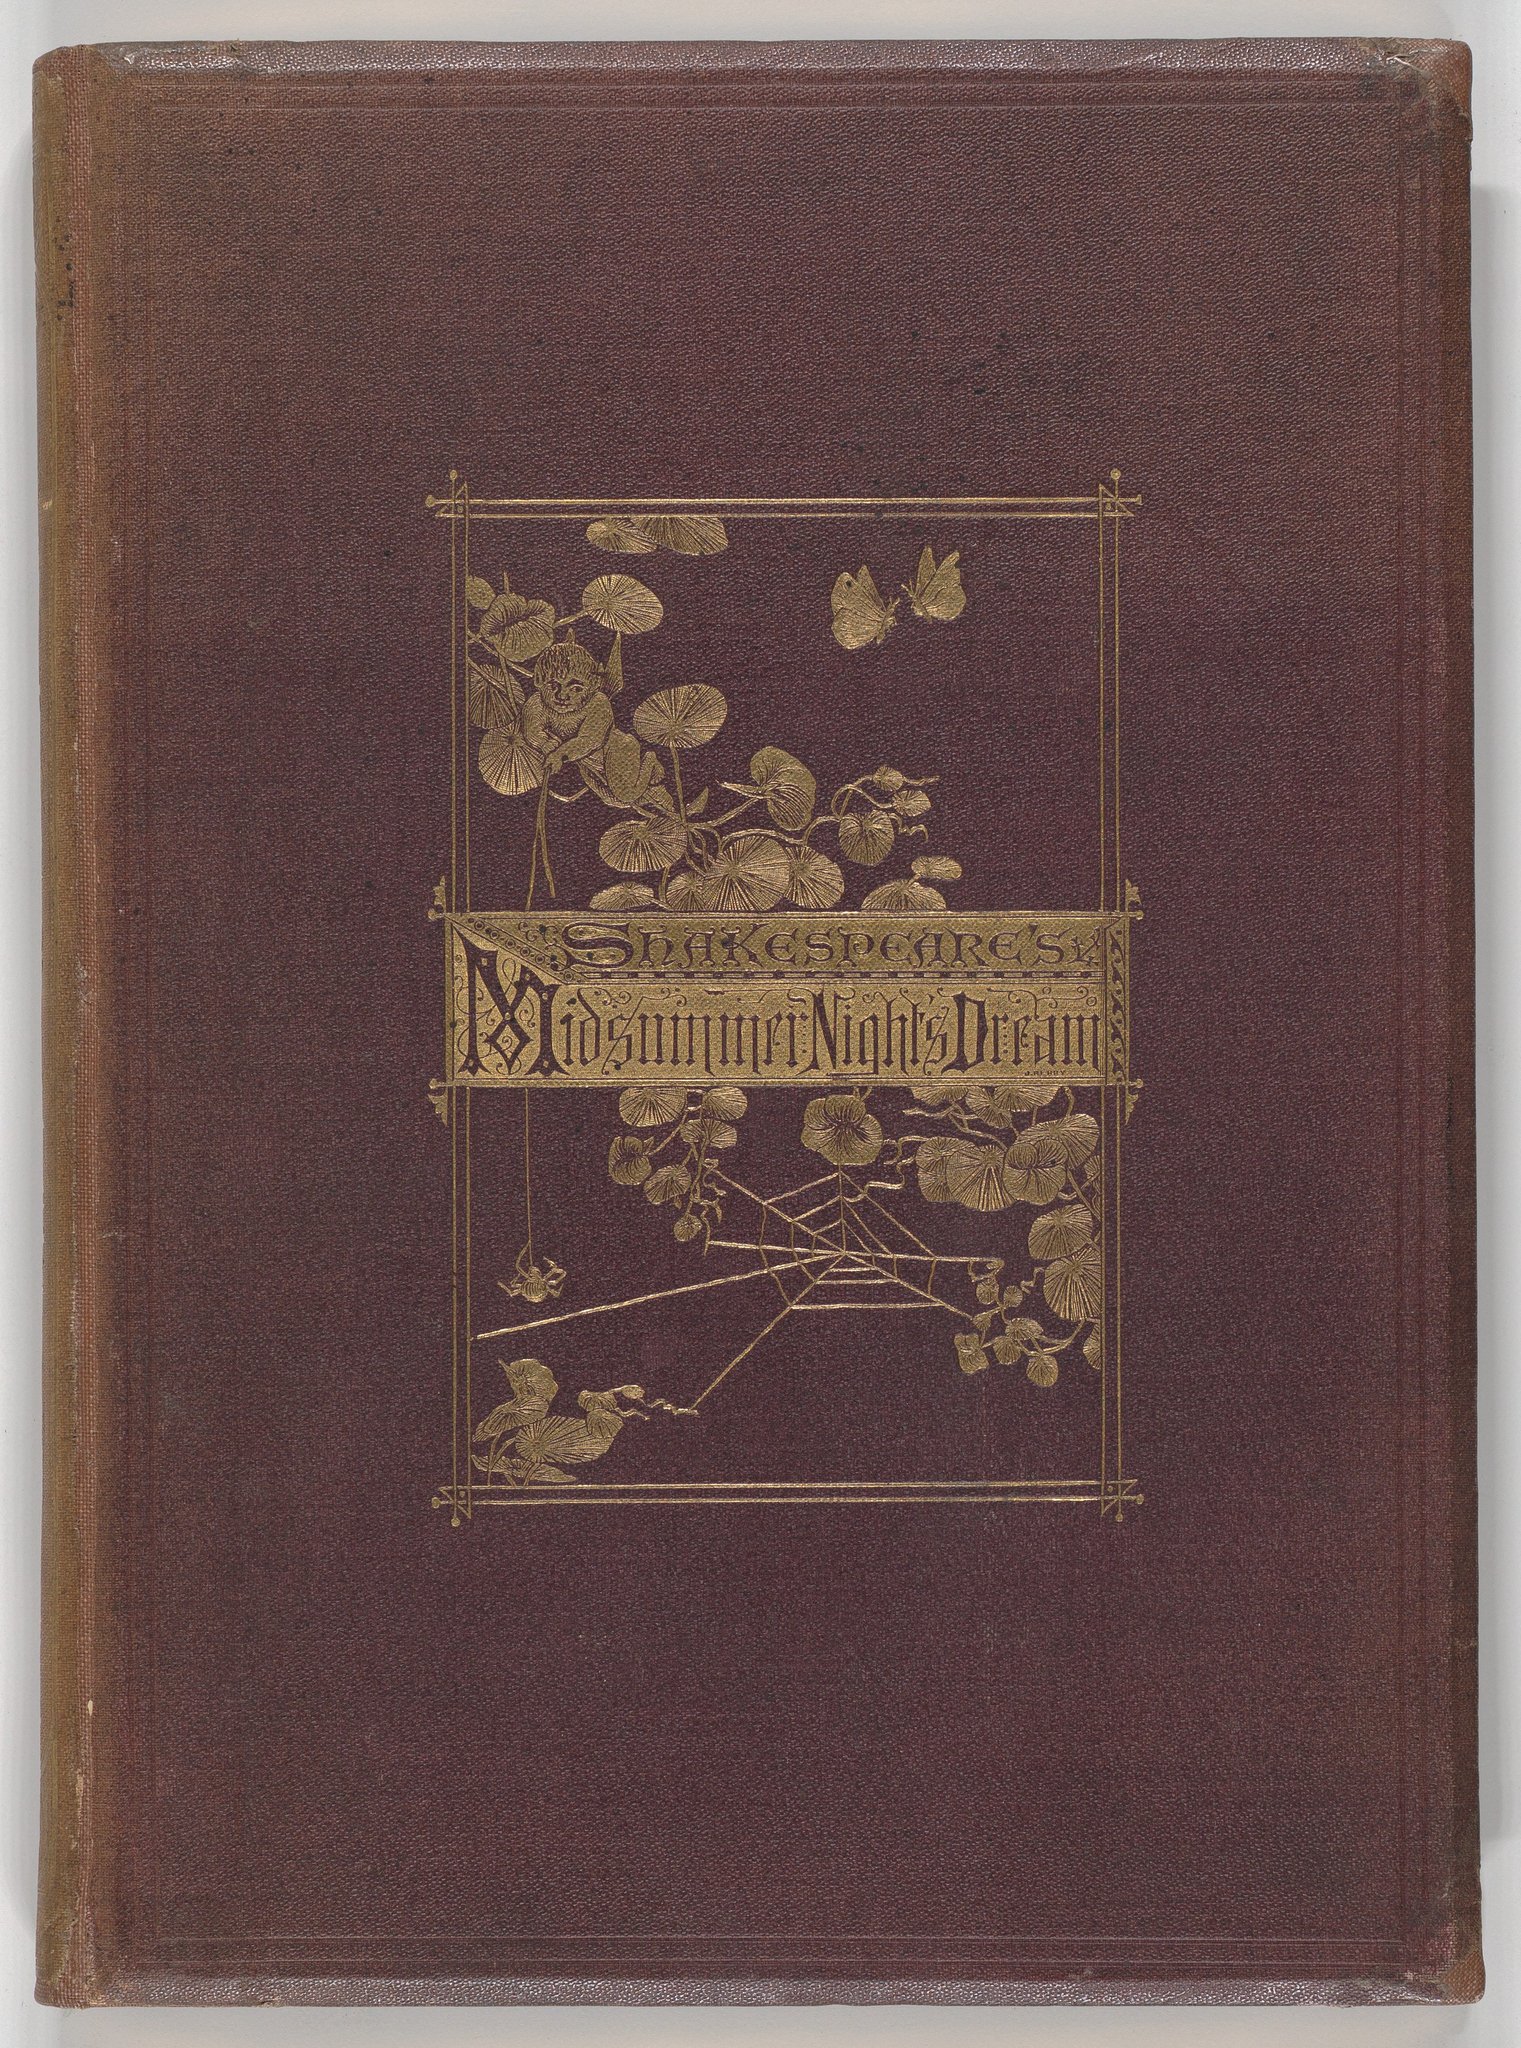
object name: book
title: Midsummer Night's Dream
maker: william shakespeare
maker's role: author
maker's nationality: british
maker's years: 1564-1616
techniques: engraving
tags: insects,butterflies,leaves